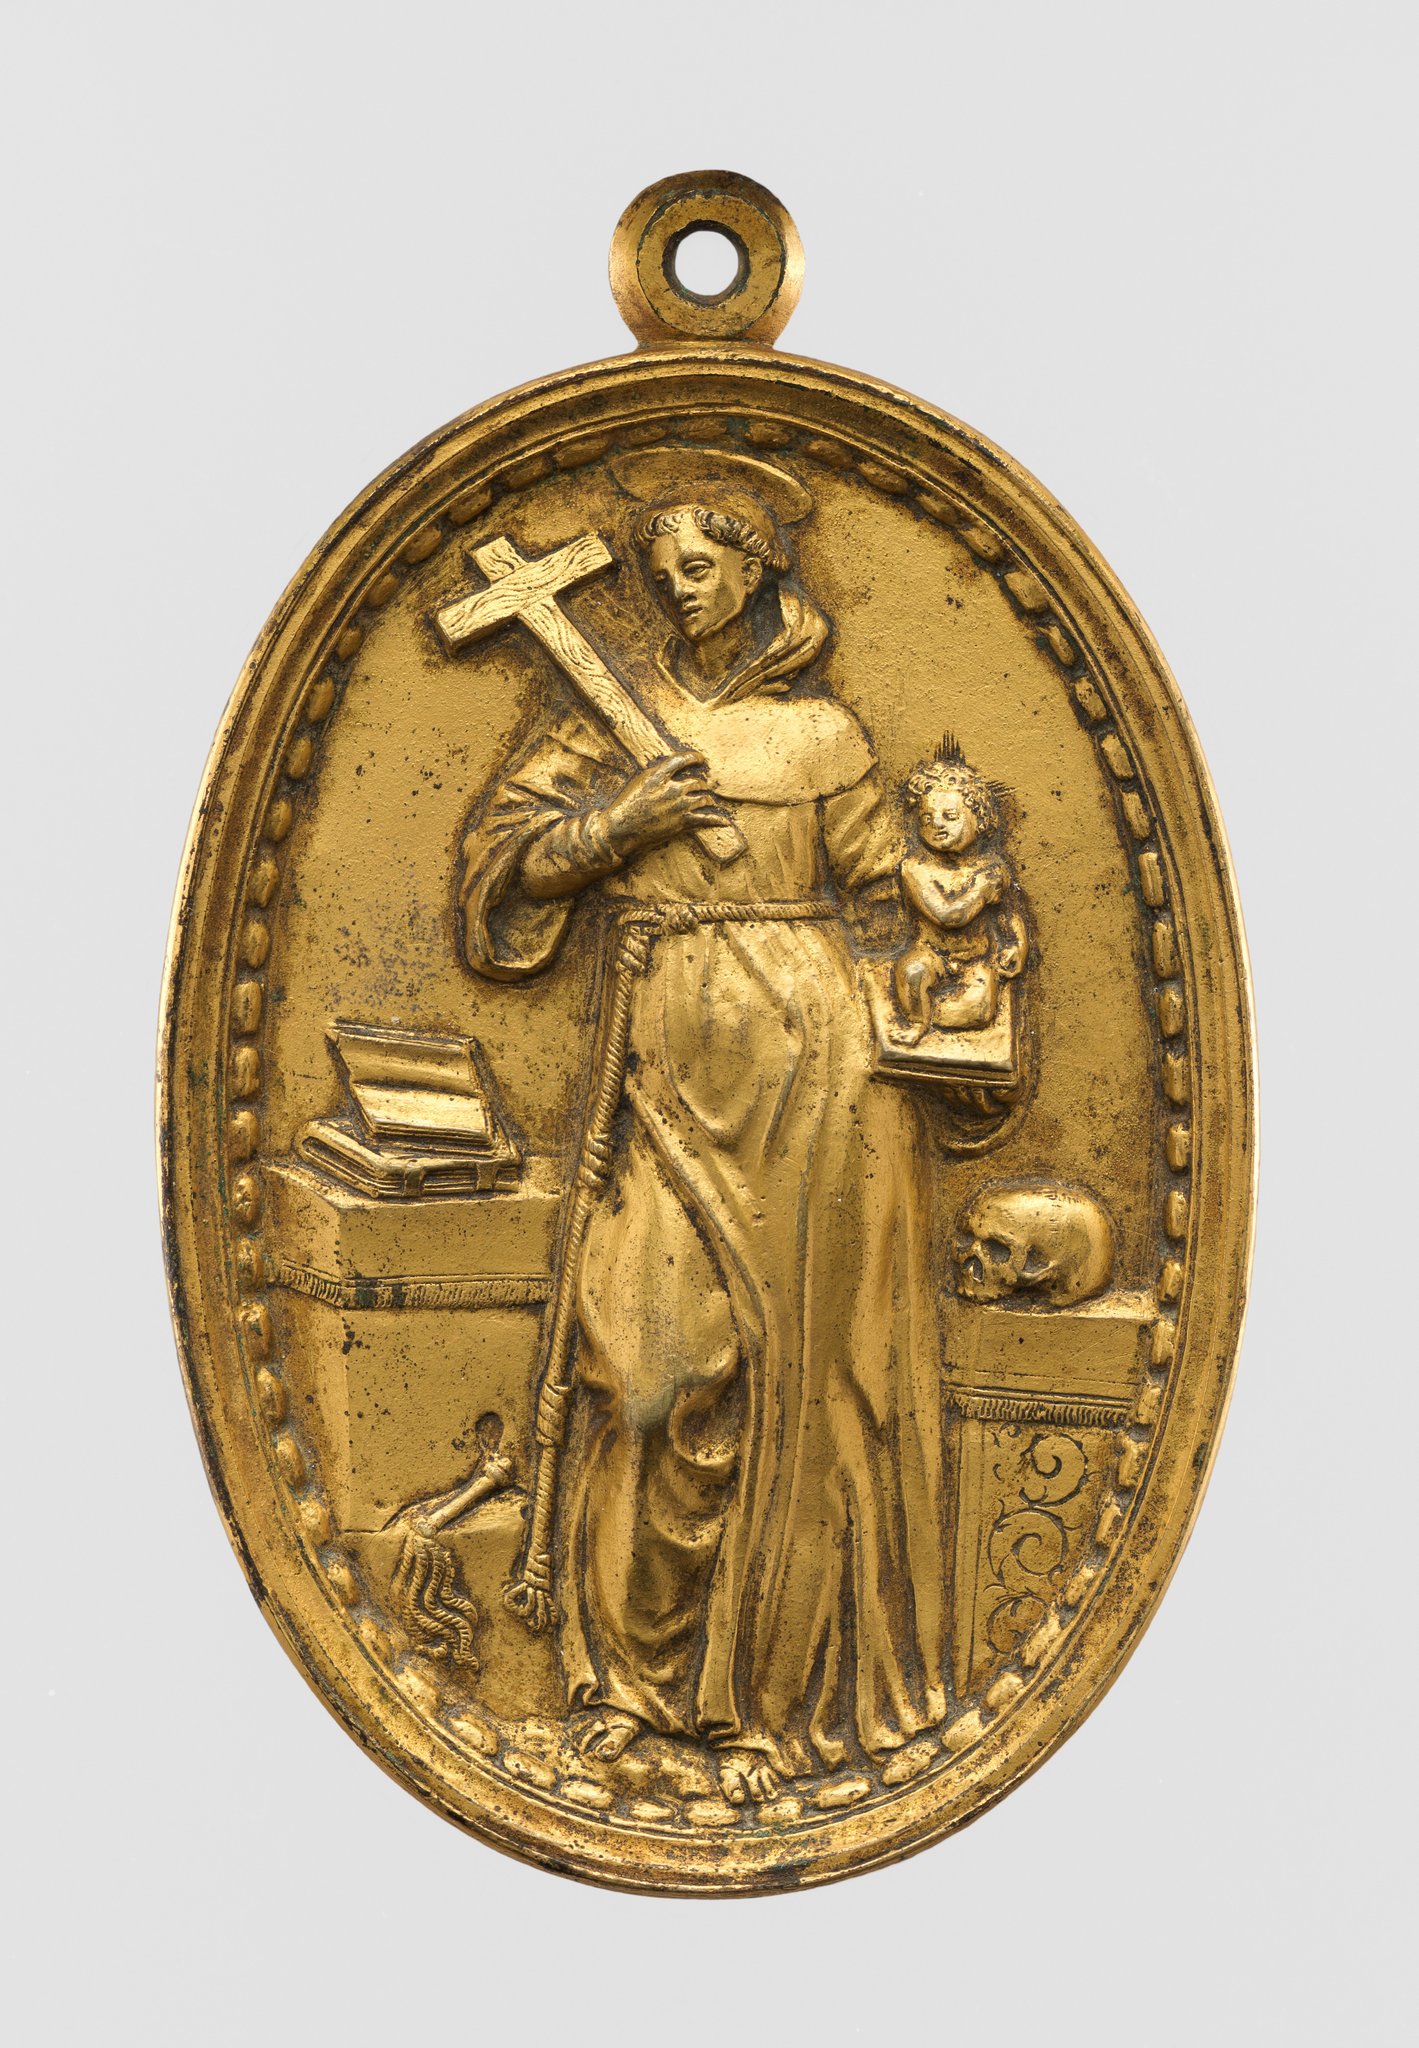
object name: plaquette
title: Saint Anthony of Padua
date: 1601-1633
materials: gilt bronze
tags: books,skulls,infants,saint anthony,cross